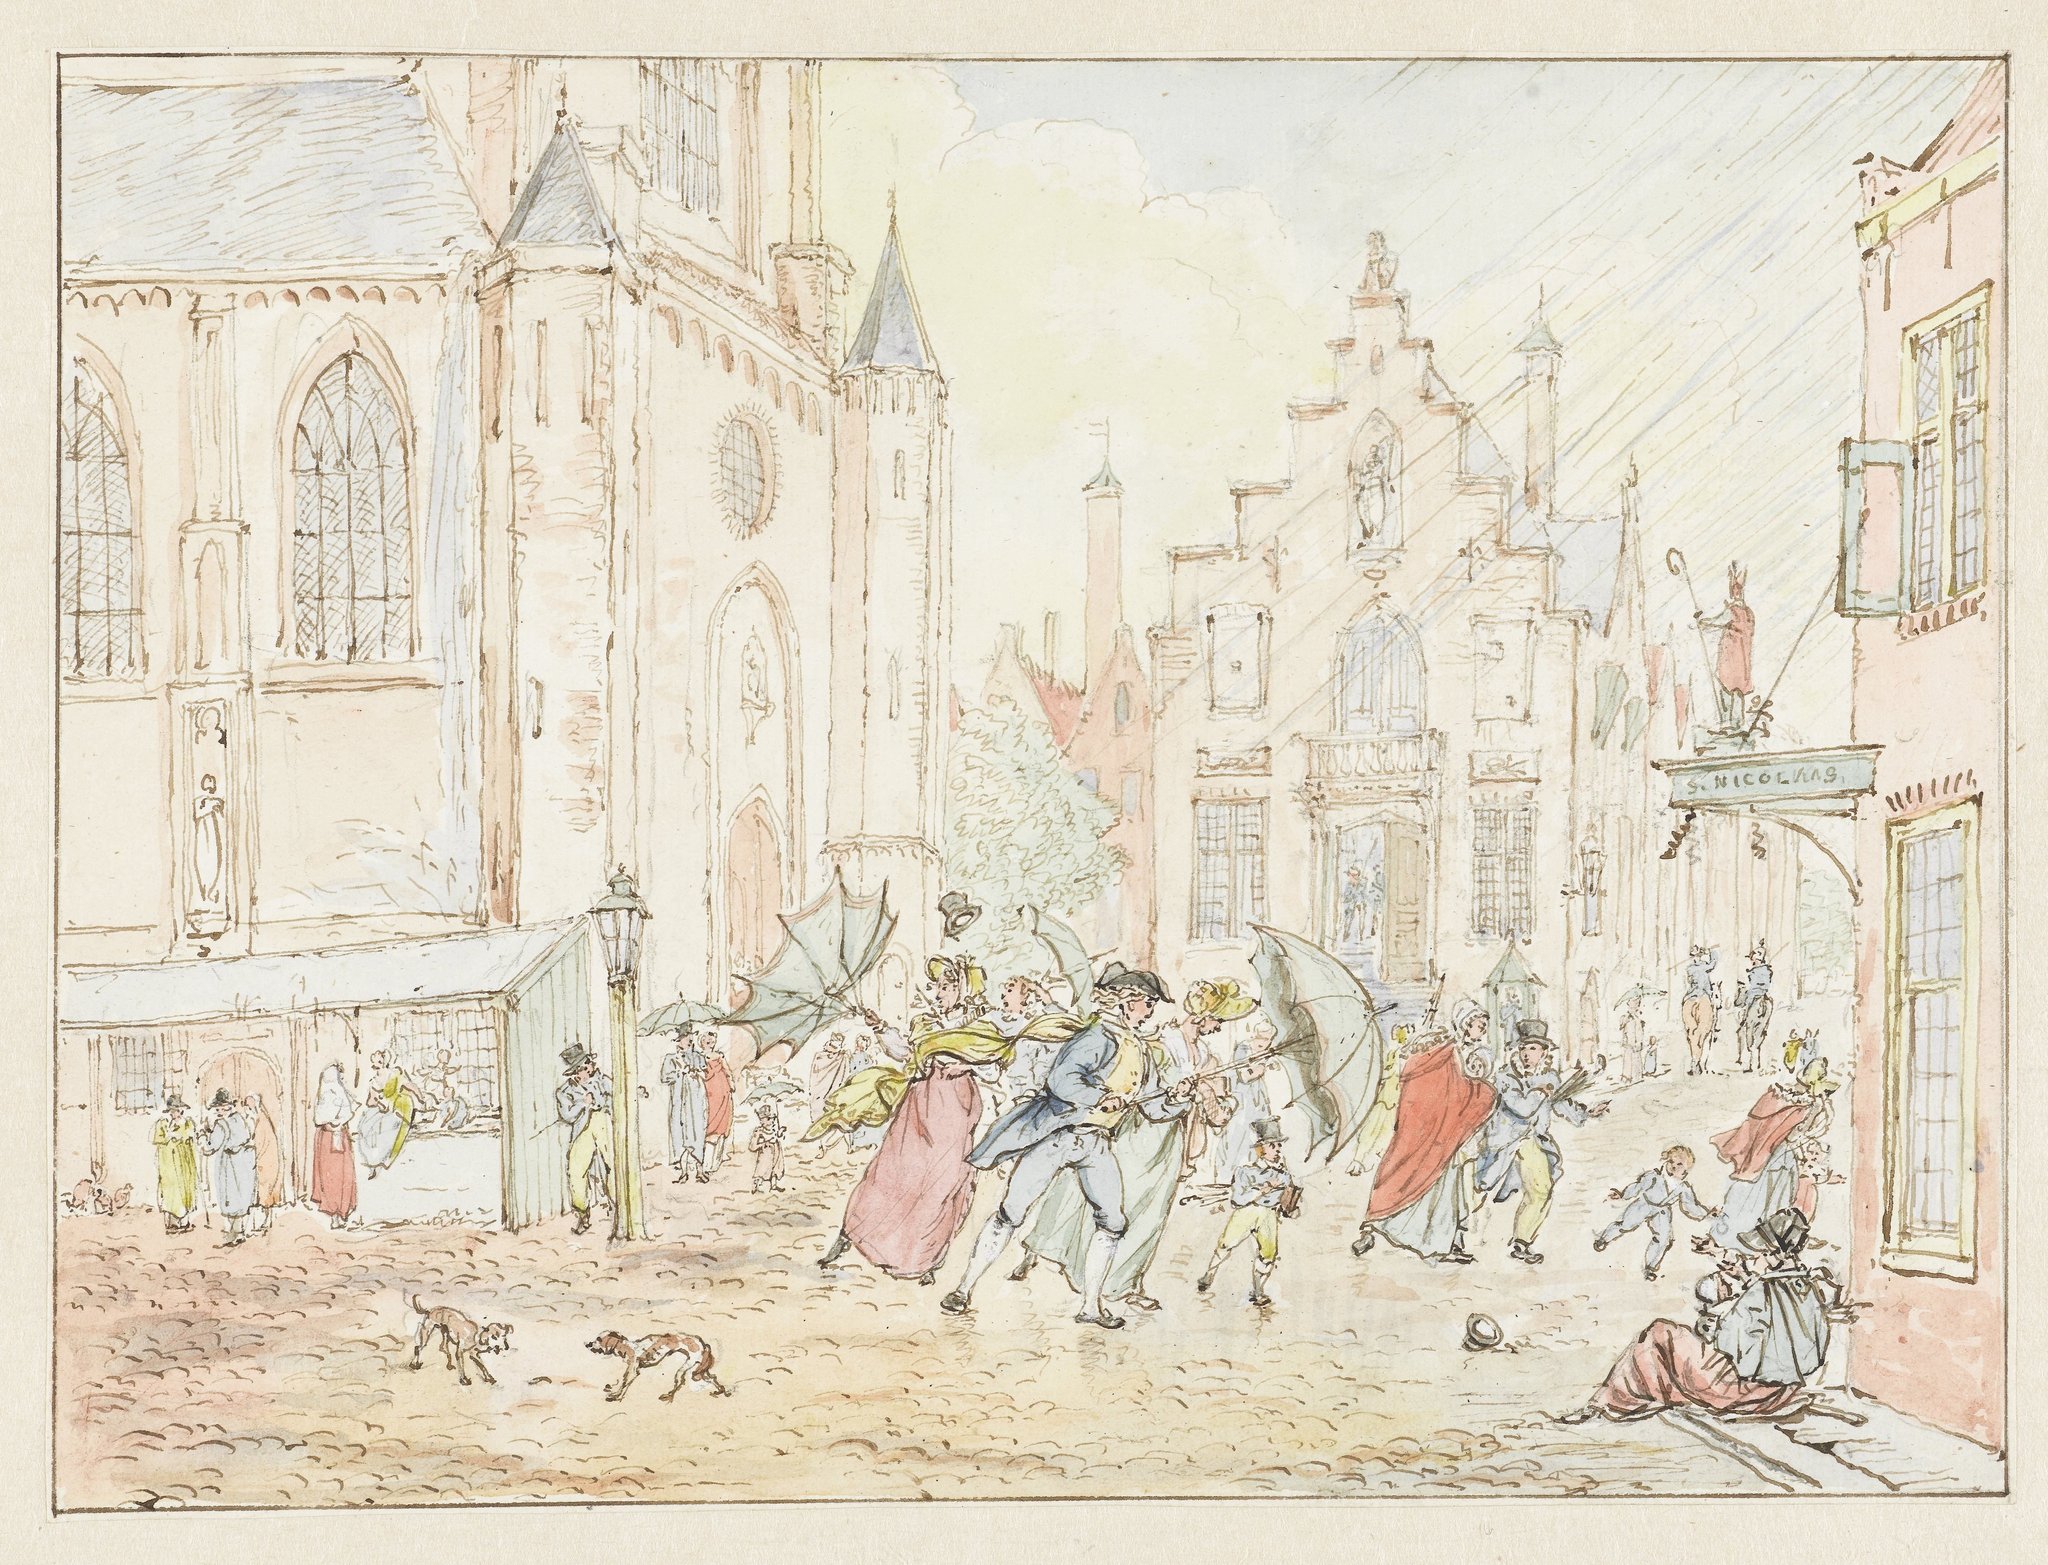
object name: watercolor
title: Plein met mensen in de regen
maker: pieter bartholomeusz. barbiers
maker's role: draughtsman, print maker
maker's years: 1772-1837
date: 1782-1837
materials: graphite, ink, paper, watercolor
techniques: brush, pen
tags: square, place, circus, etc.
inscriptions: : ‘Eerste gedagte op de Zinspreuk na Reegen komt Zonneschijn’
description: Verbeelding van het gezegde 'Na regen komt zonneschijn'.